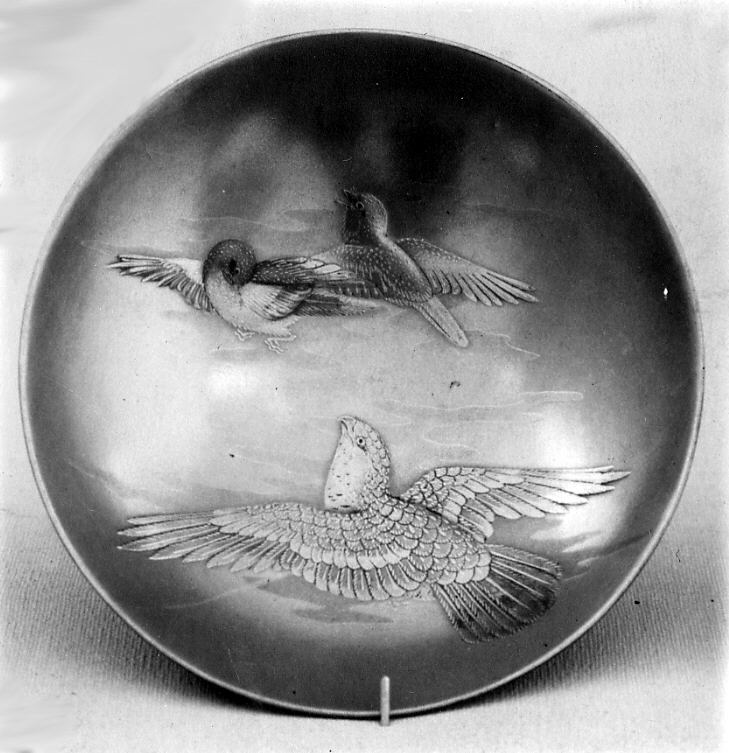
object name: wine cup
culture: japanese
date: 1867-1900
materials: gold, lacquer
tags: eagles